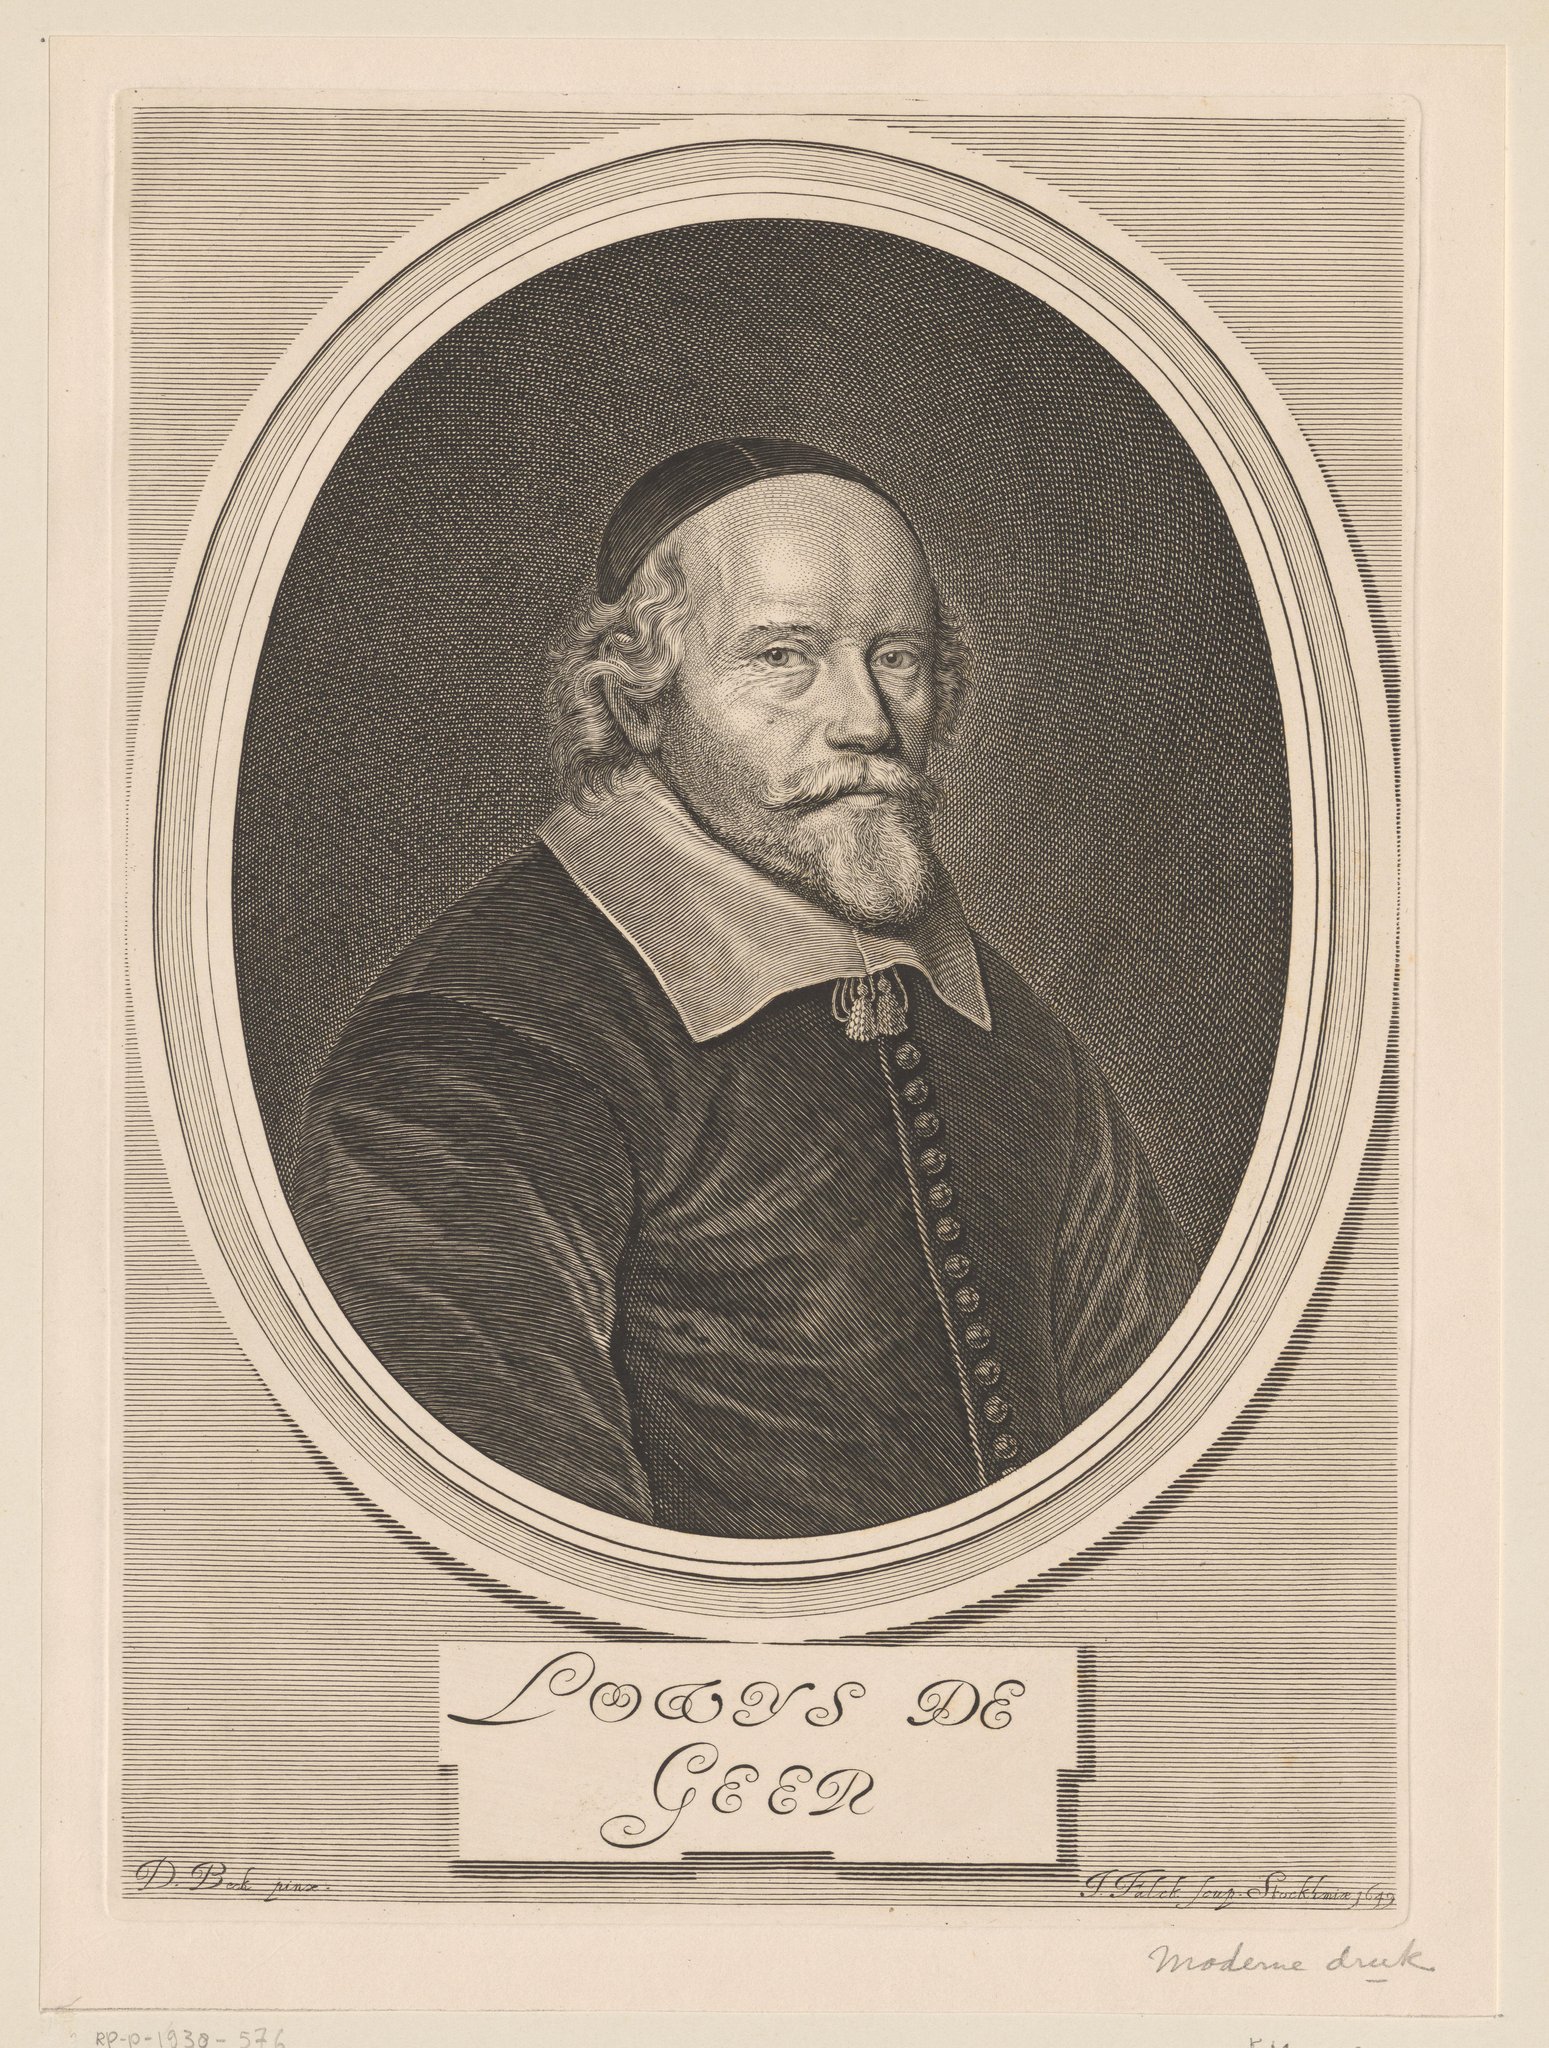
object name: print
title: Portret van Louis de Geer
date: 1649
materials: paper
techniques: engraving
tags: amsterdam, historical persons, merchant, salesman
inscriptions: collector's mark: Lugt 2228